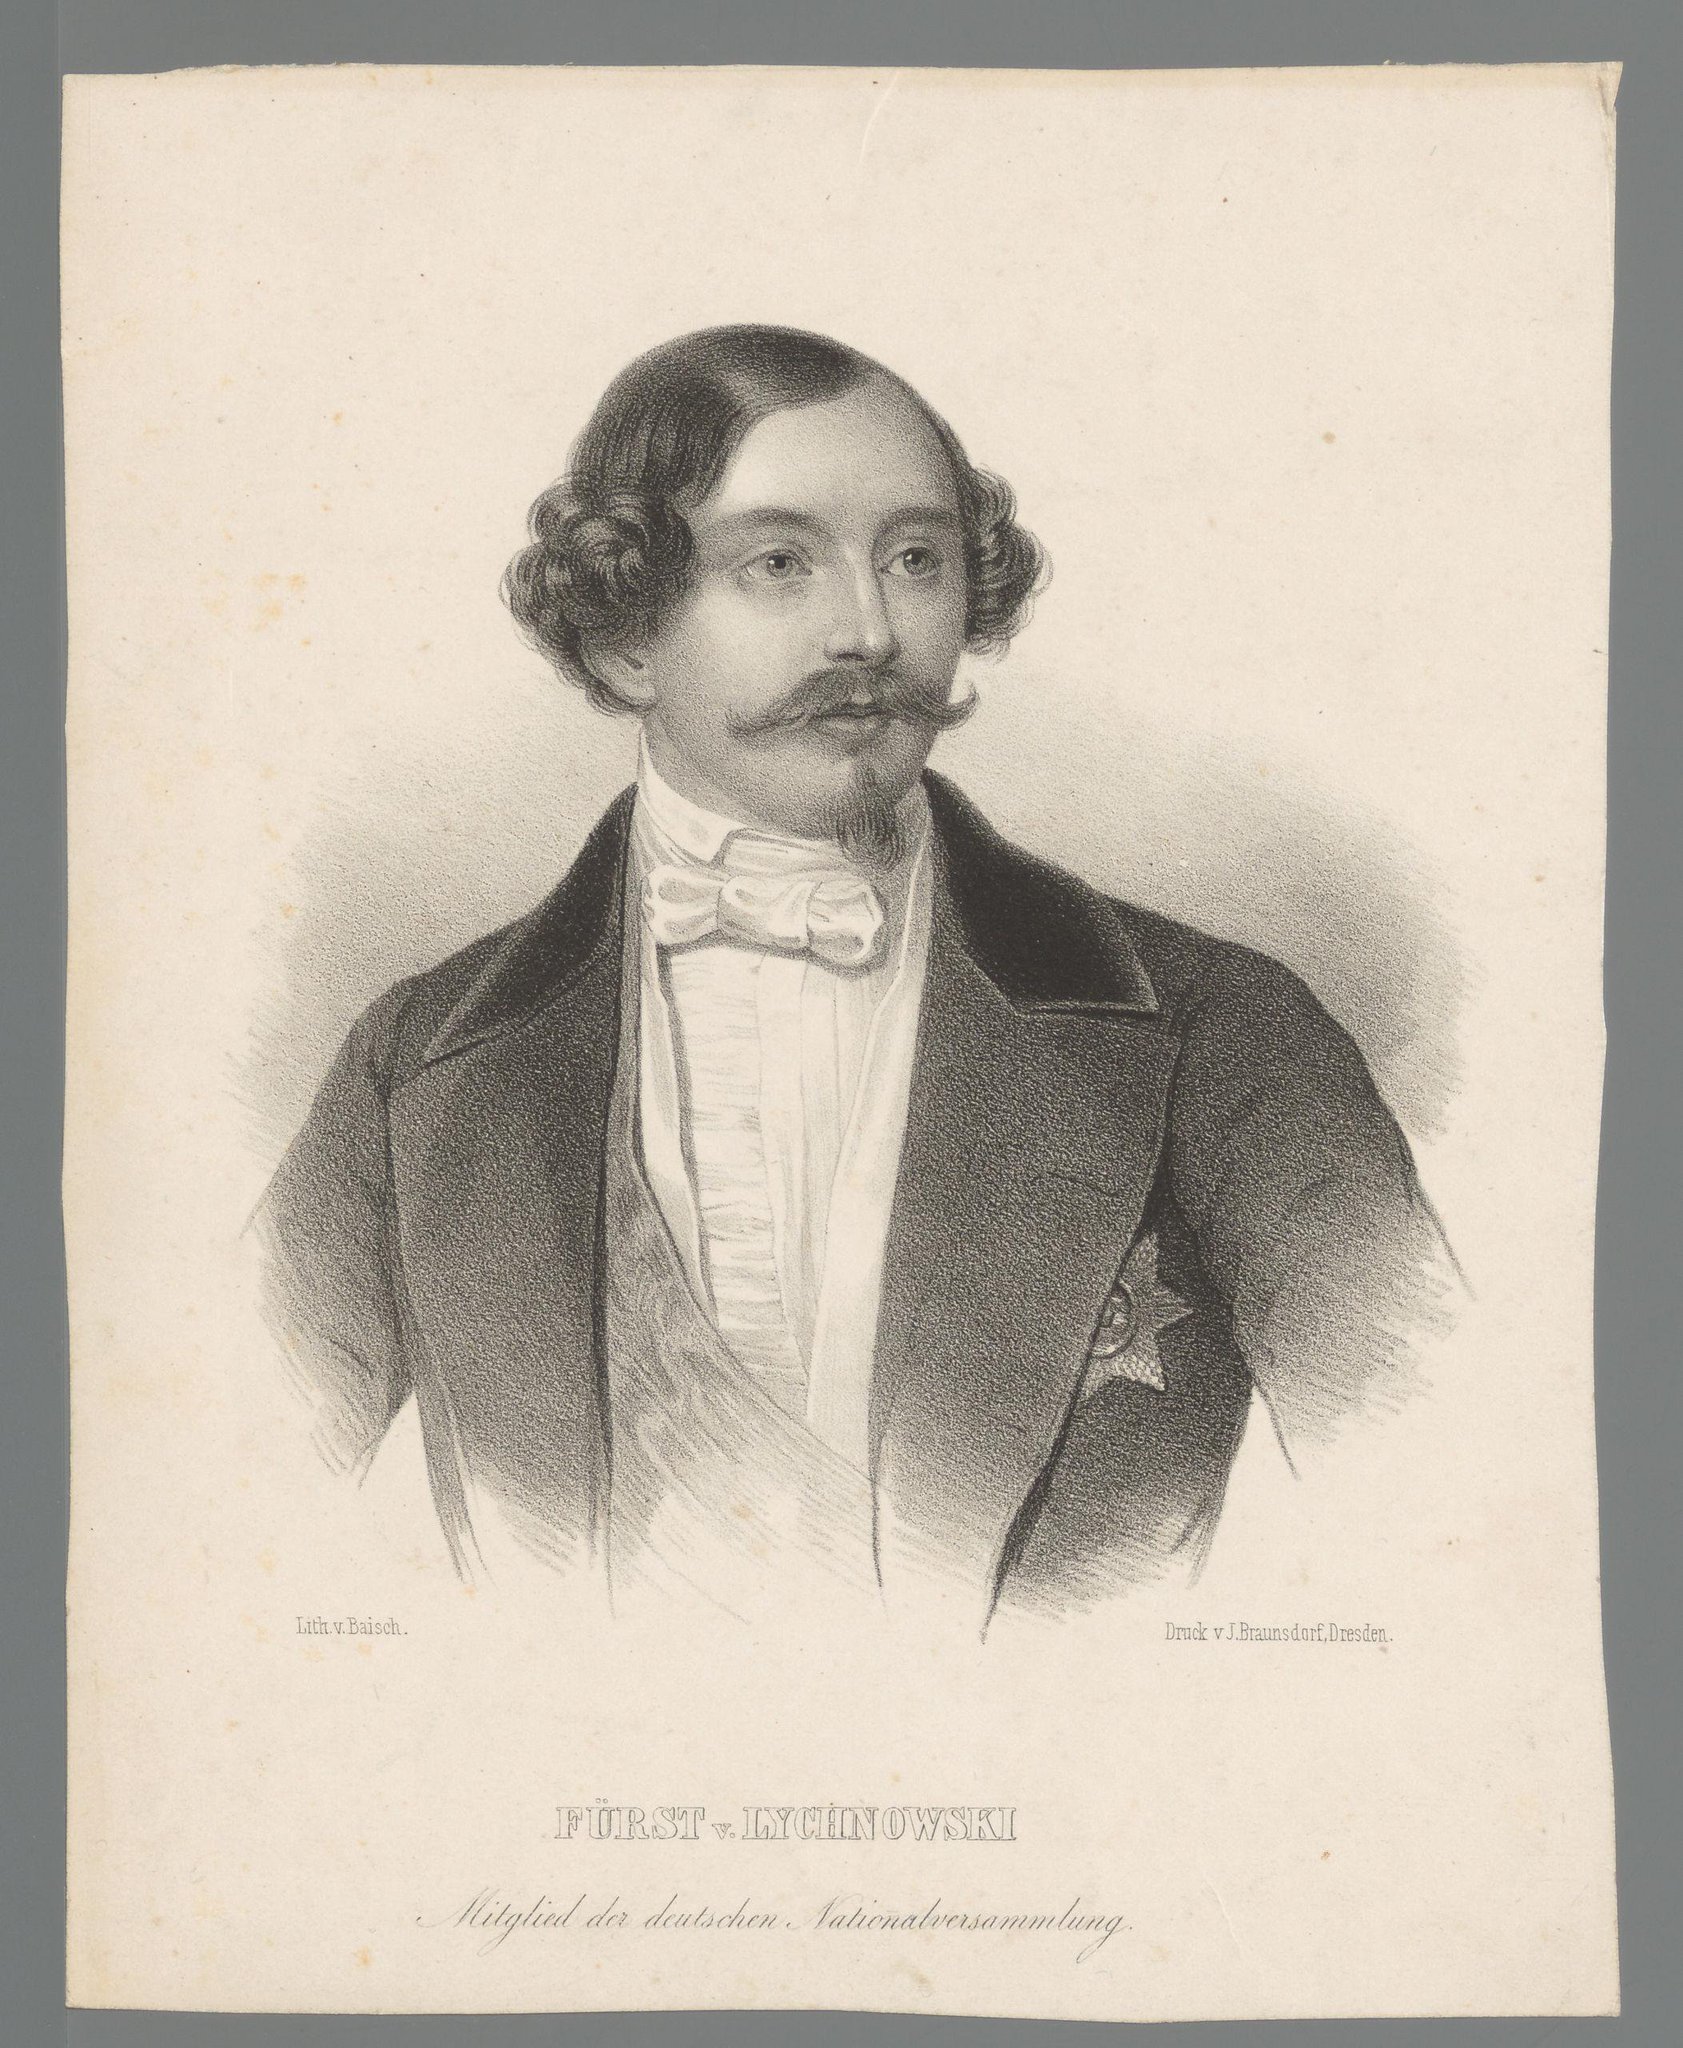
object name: print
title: Portret van Felix Maria Vincenz Andreas von Lichnowsky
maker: wilhelm heinrich gottlieb baisch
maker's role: print maker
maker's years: 1805-1864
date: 1815-1864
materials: paper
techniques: lithograph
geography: dresden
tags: prince, historical persons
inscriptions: collector's mark: Lugt 2228